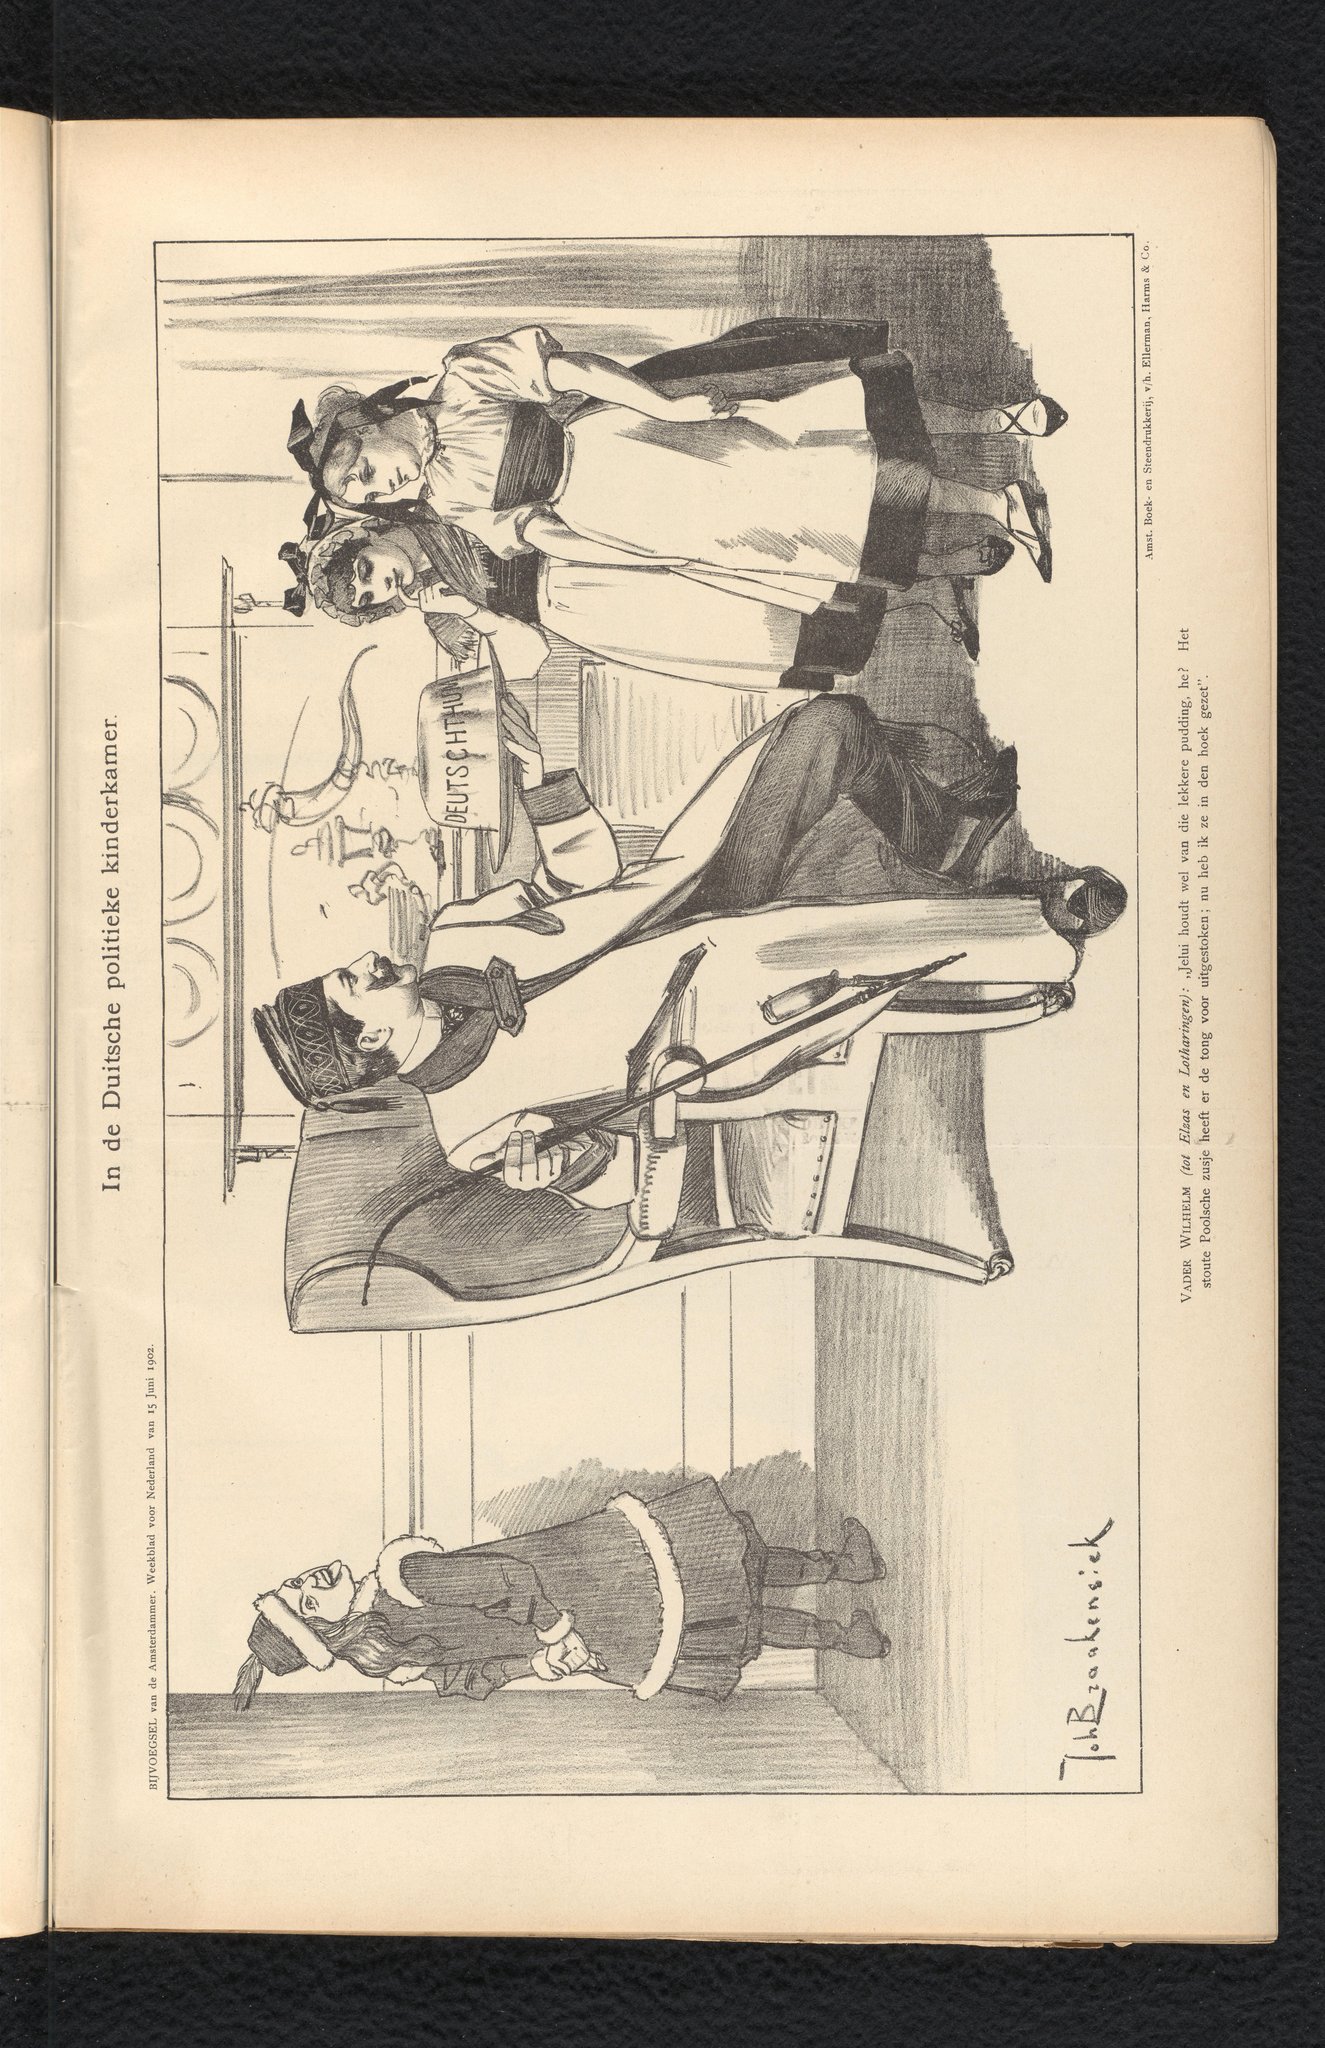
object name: cartoon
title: In de Duitsche politieke kinderkamer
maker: johan braakensiek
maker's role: draughtsman, print maker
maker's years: 1858-1940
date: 1902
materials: paper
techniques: lithograph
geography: amsterdam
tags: wilhelm ii (keizer van duitsland), fancy-cakes, fancy-pastries, personifications of countries, nations, states, districts, etc., the good child versus the naughty child, political caricatures and satires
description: De Duitse keizer Wilhelm II als een vader die zijn twee dochters Elzas en Lotharingen de aanlokkelijke pudding 'Deutschthum' voorhoudt, het stoute zusje Polen heeft hij in de hoek van de kamer gezet.